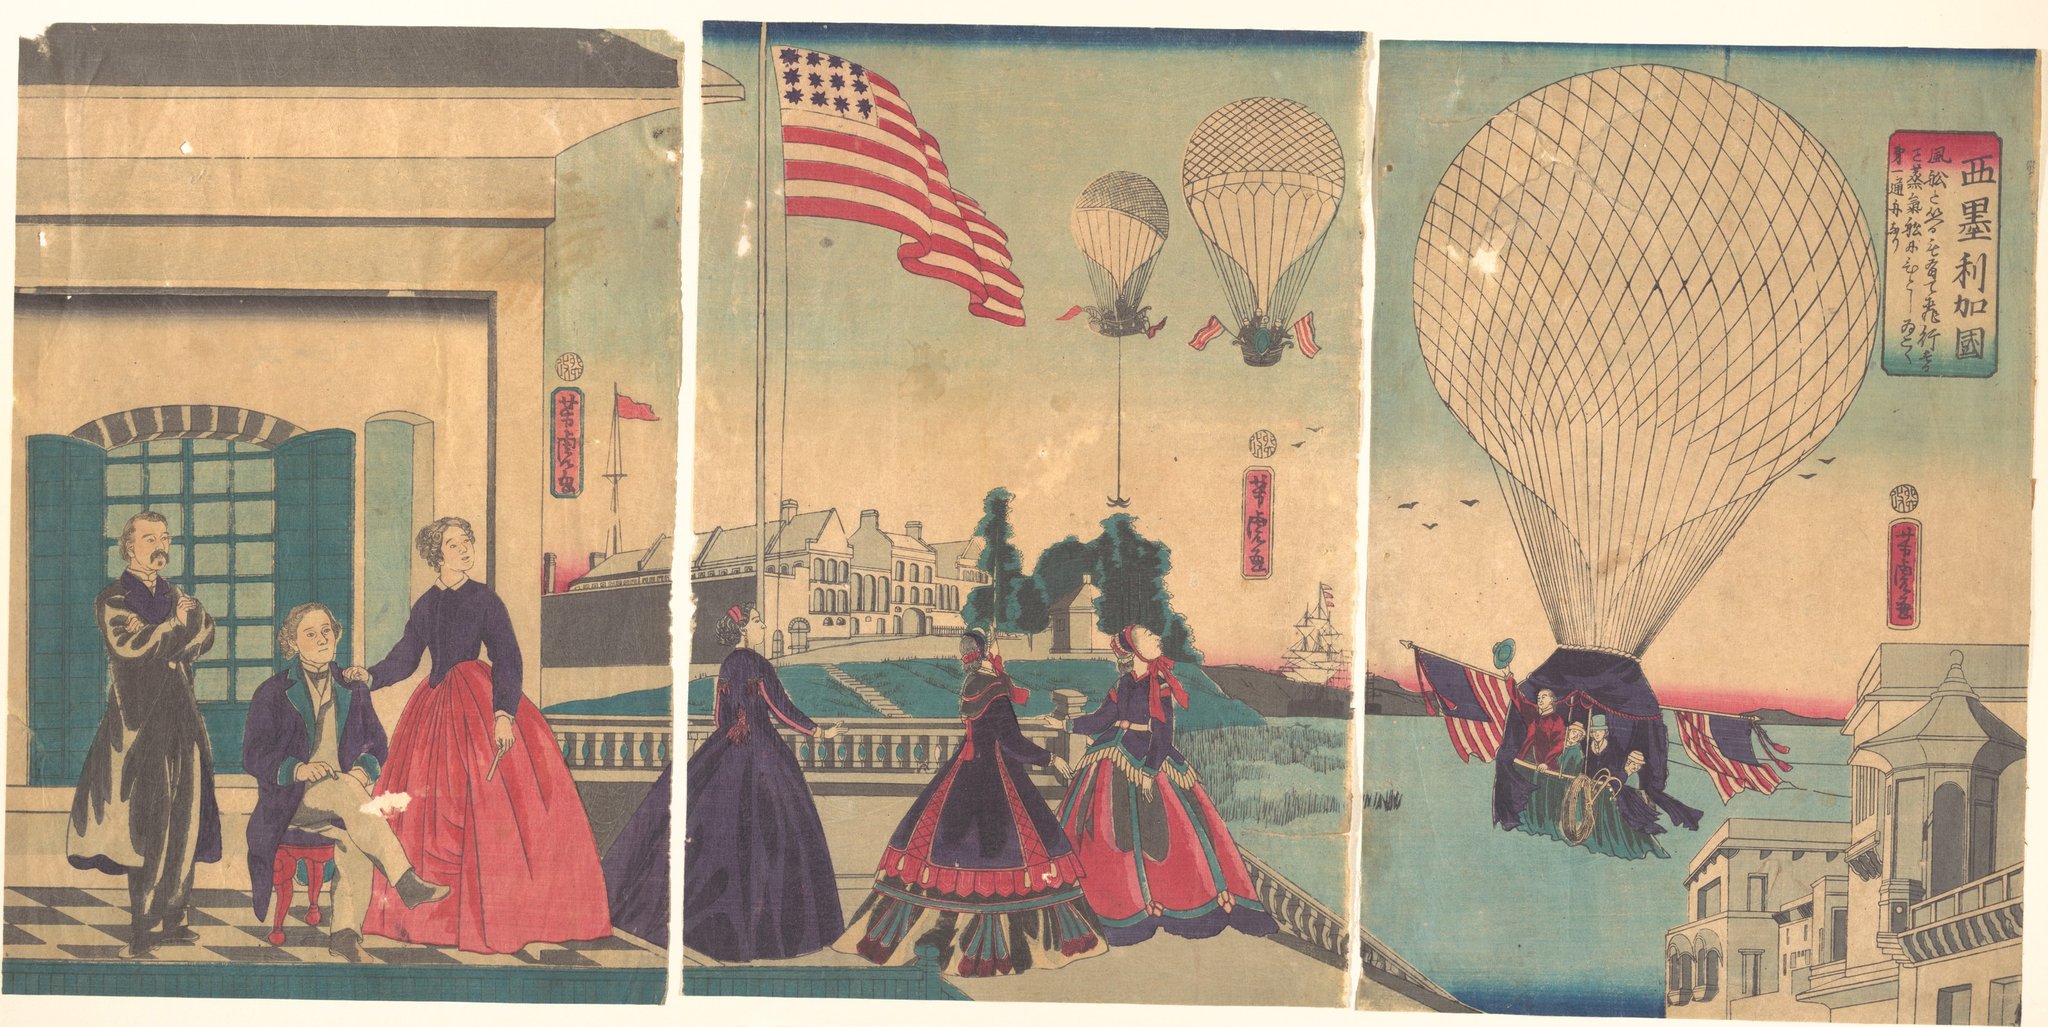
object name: print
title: American Balloon Ascension (Amerikakoku)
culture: japanese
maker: utagawa yoshitora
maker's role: artist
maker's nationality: japanese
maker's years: 1845-1880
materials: ink, paper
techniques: woodblock print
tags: men,women,flags,hot air balloons